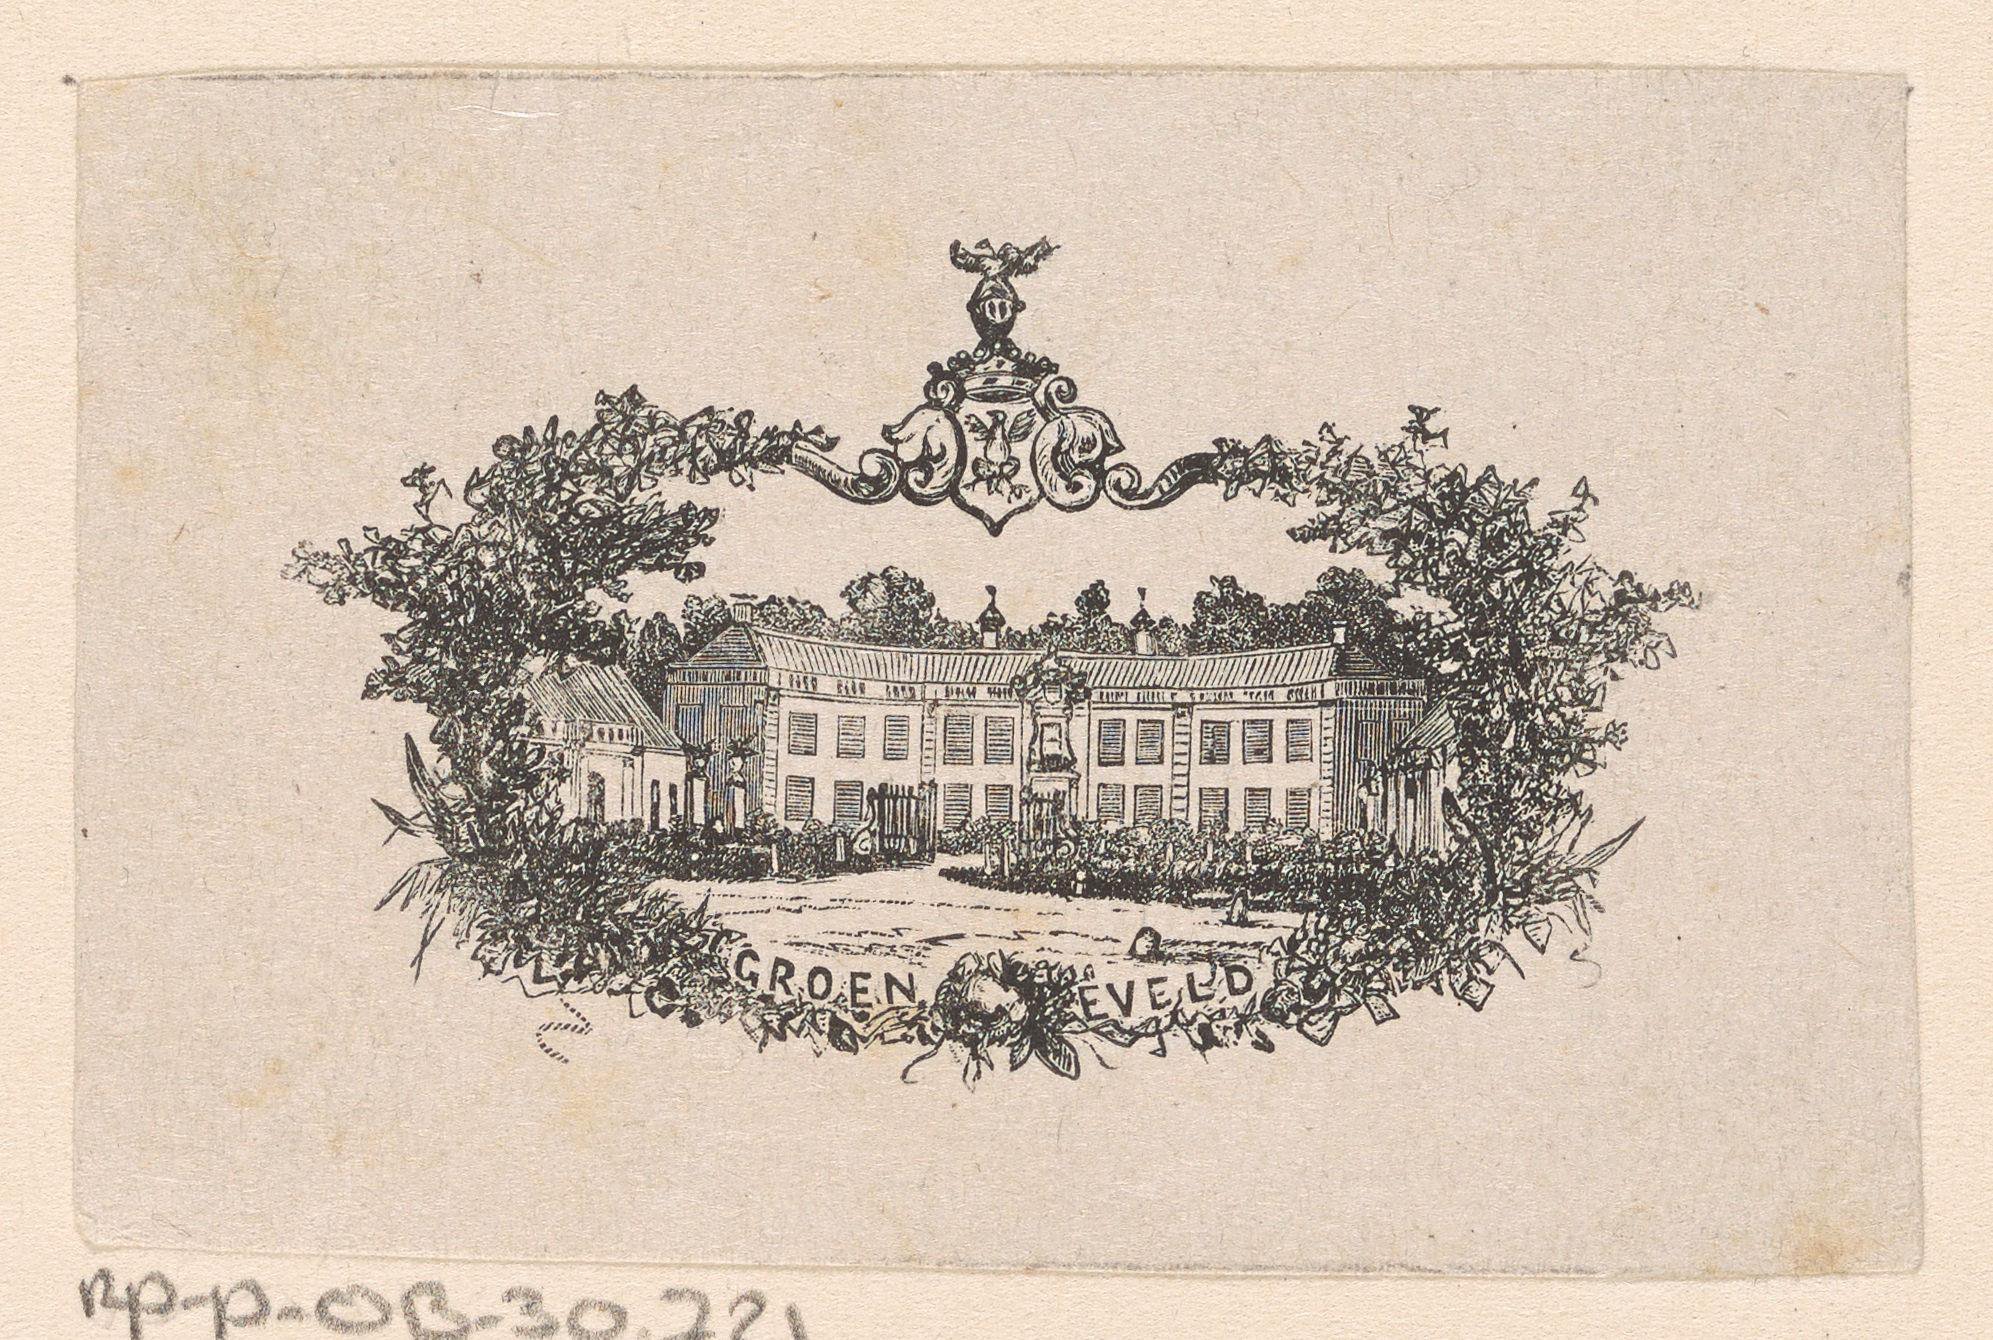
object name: print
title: Kasteel Groeneveld te Baarn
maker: isaac weissenbruch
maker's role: print maker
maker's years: 1826-1912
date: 1836-1912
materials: paper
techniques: engraving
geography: netherlands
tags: castle